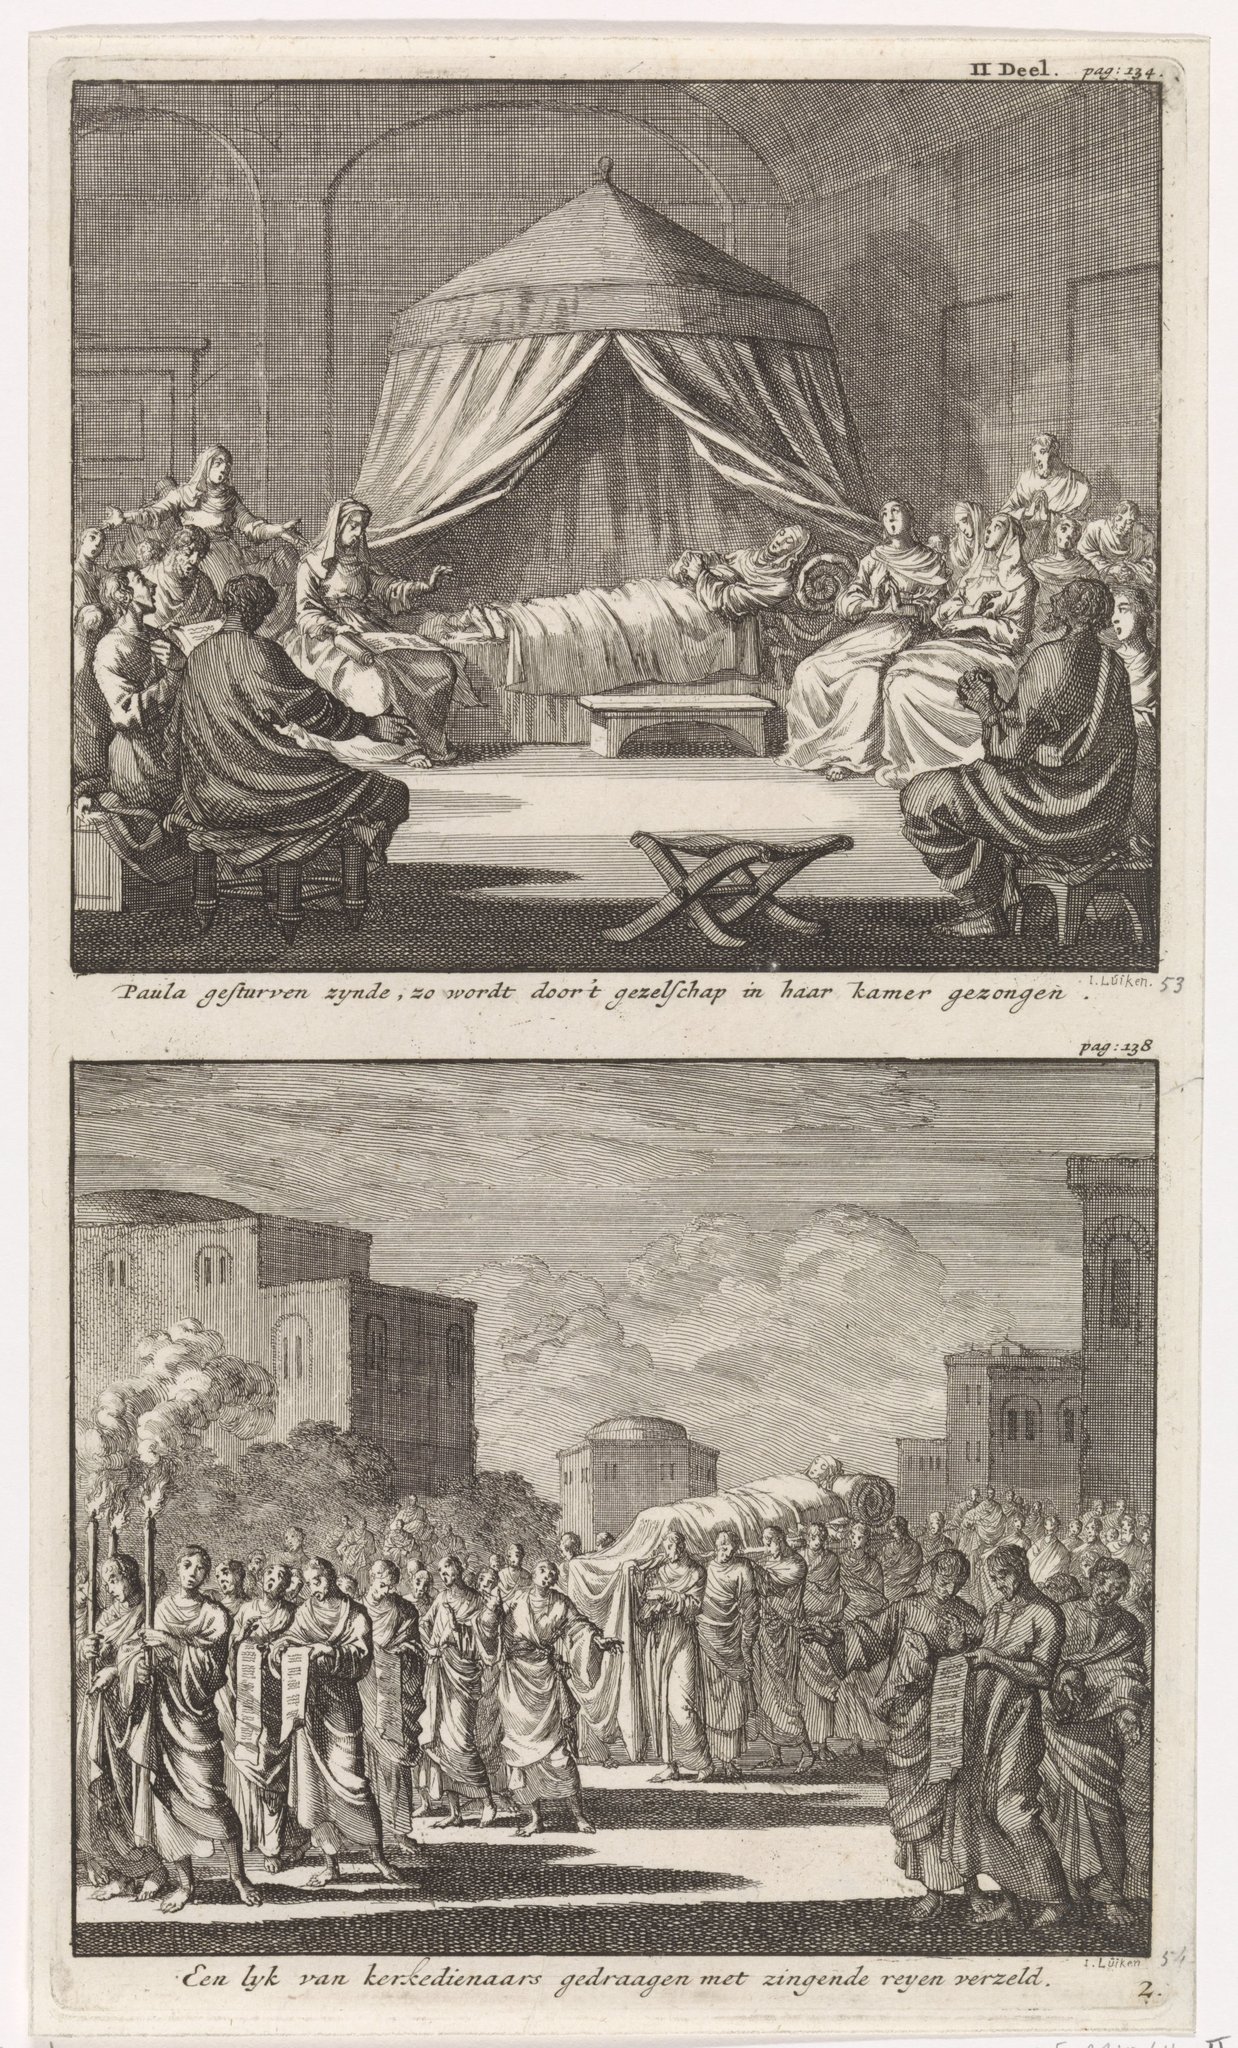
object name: print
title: Paula gesturven zynde, zo wordt door't gezelschap in haar kamer gezongen / Een lyk van kerkdienaars gedraagen met zingende reyen verzeld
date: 1701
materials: paper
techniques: etching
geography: amsterdam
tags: singing of psalms, hymns, etc., the early christian churches, e.g. armenians, copts, syrians, female saints (paula) - death, deathbed of female saint, deathbed, cortege, funeral procession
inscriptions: collector's mark: Lugt 2228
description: Twee voorstellingen op een plaat. Boven: de H. Paula van Rome op haar doodsbed. Rondom het ledikant een groep gelovige christen die zingen. Onder: een processie gelovigen. Ze dragen kaarsen en zingen. In het midden de lijkberie met de H. Paula van Rome. Ze wordt naar haar graf gedragen.